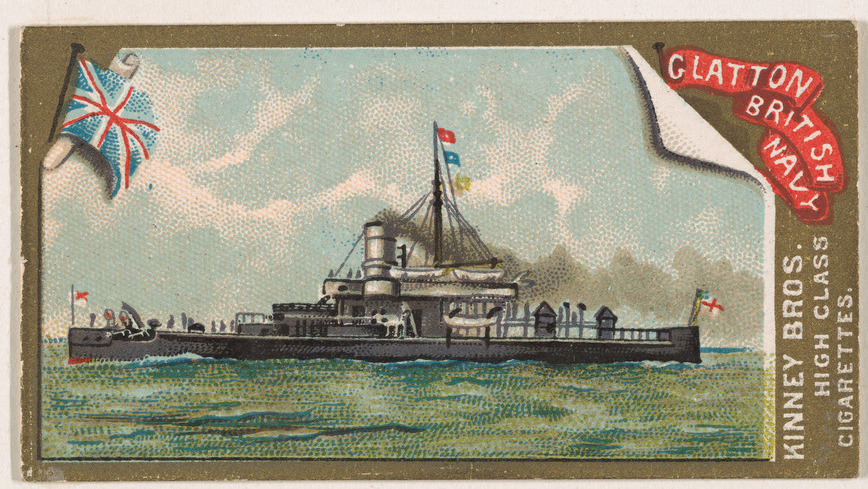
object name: print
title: H.M.S. Glatton, British Navy, from the Naval Vessels of the World series (N226) issued by Kinney Bros.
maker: kinney brothers tobacco company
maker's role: publisher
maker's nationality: american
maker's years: 1869-2011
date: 1889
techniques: color lithograph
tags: navy,ships